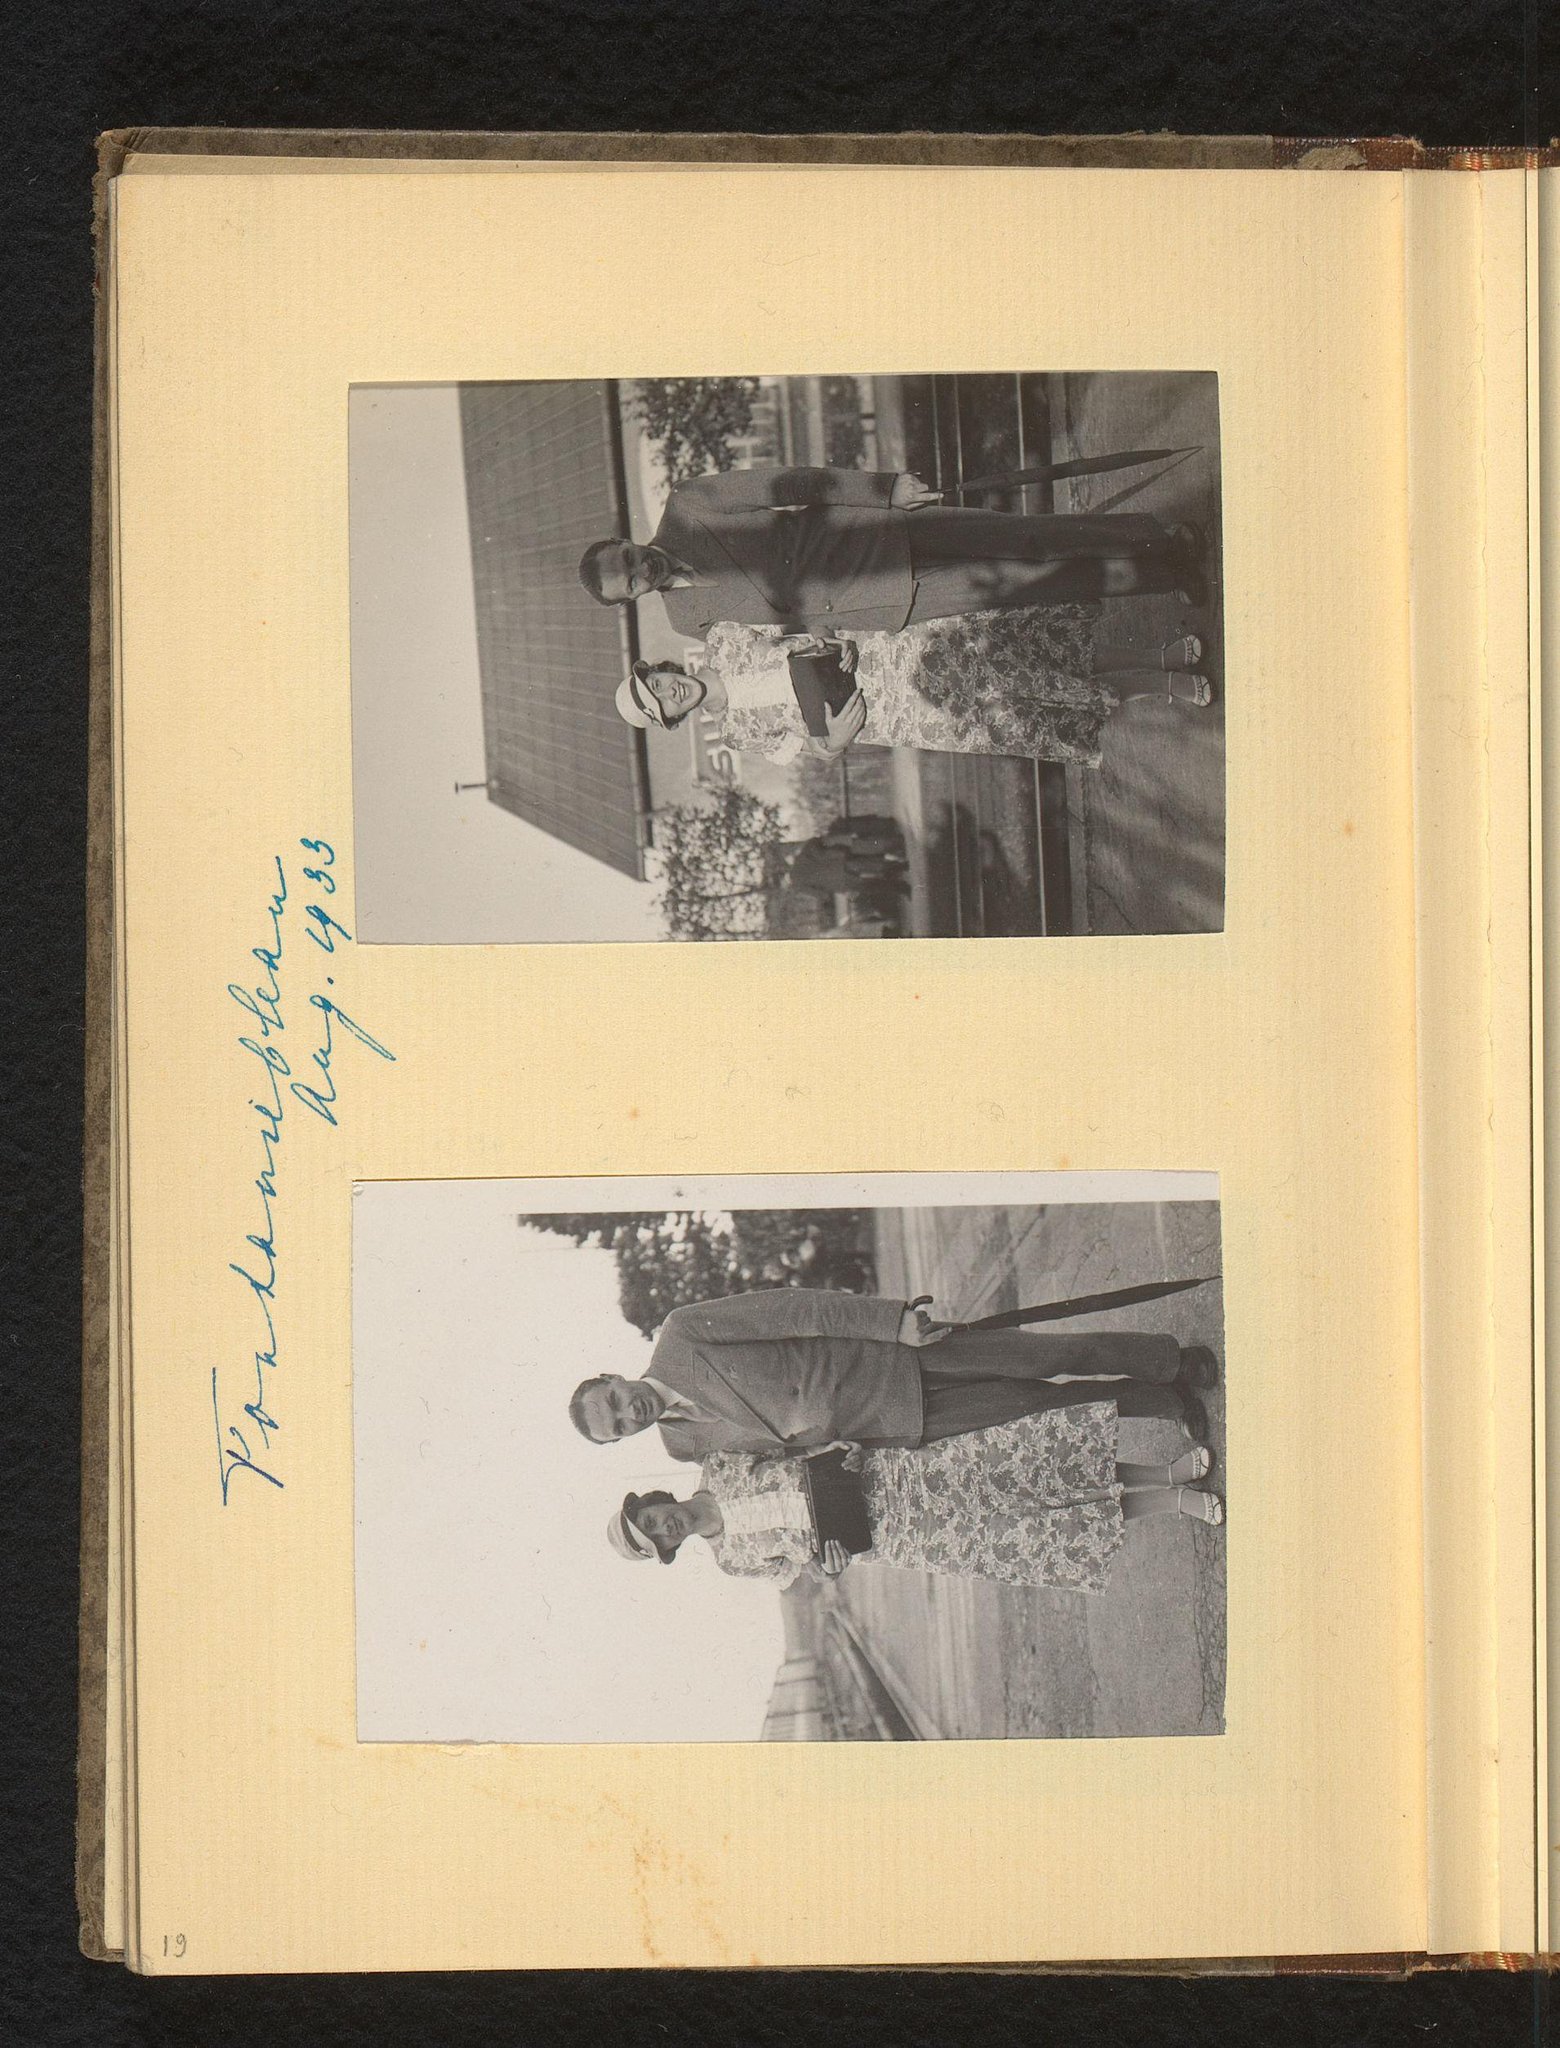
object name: album leaf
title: Fontainebleau Aug. 1933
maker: Anonymous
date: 1908-1933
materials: paper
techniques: gelatin silver print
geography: fontainebleau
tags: amsterdam, historical persons, couple of lovers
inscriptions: inscription: ‘Fontainebleau Aug. 1933’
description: Deze foto's maken deel uit van een album.